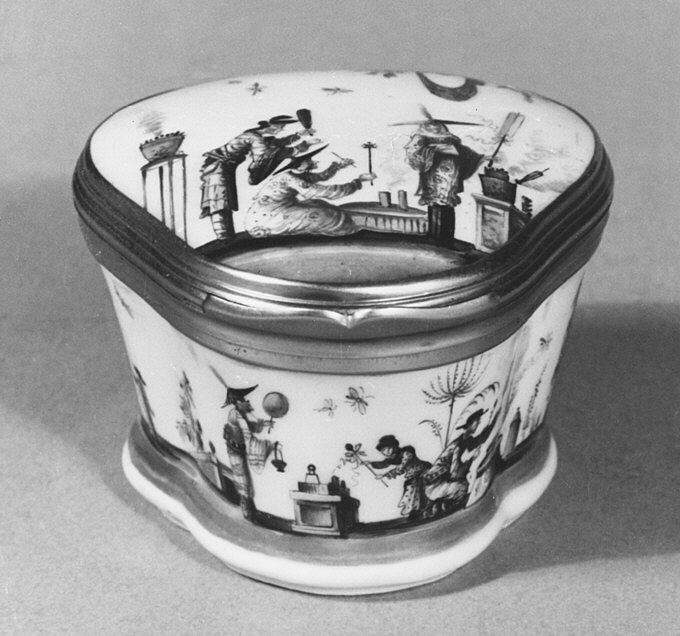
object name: snuffbox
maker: meissen manufactory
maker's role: manufactory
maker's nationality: german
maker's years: 1710-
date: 1730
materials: gold, hard paste porcelain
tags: human figures,insects